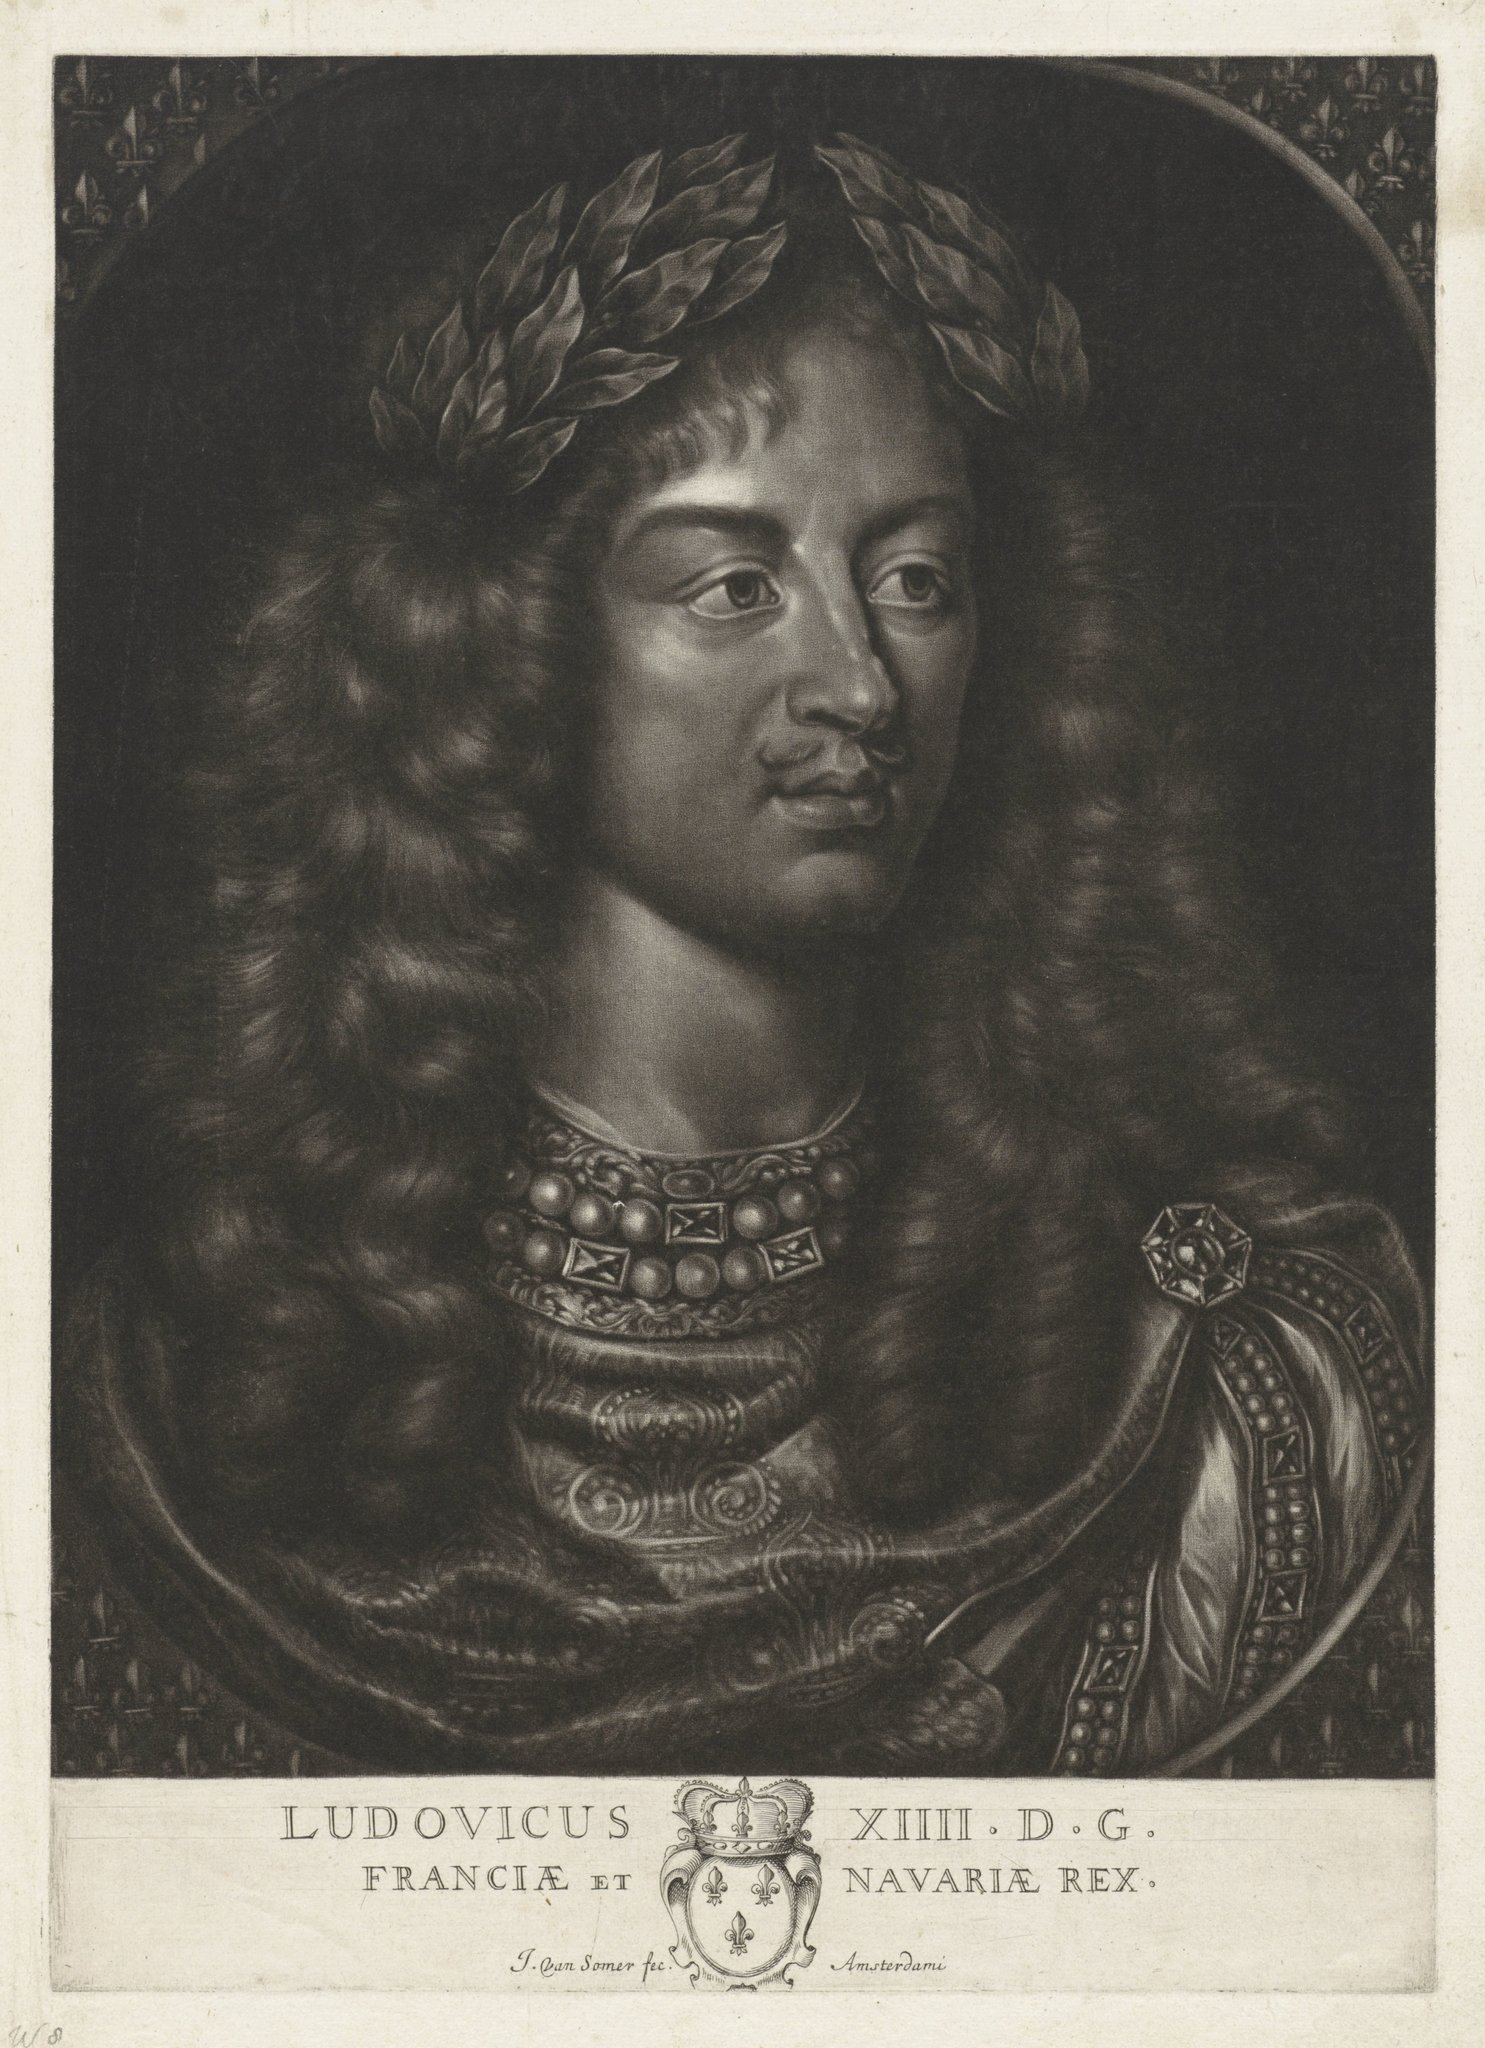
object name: print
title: Portret van Lodewijk XIV, koning van Frankrijk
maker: jan van somer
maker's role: draughtsman, print maker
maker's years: 1645-1699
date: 1655-1700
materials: paper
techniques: mezzotint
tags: lodewijk xiv (koning van frankrijk), crowning with laurel, pearl; pearl necklace (+ women's clothes)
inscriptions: collector's mark: Lugt 2228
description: Lodewijk XIV, koning van Frankrijk, met parels op zijn kleding en een lauwerkrans op het hoofd. In de marge zijn titels en zijn familiewapen.